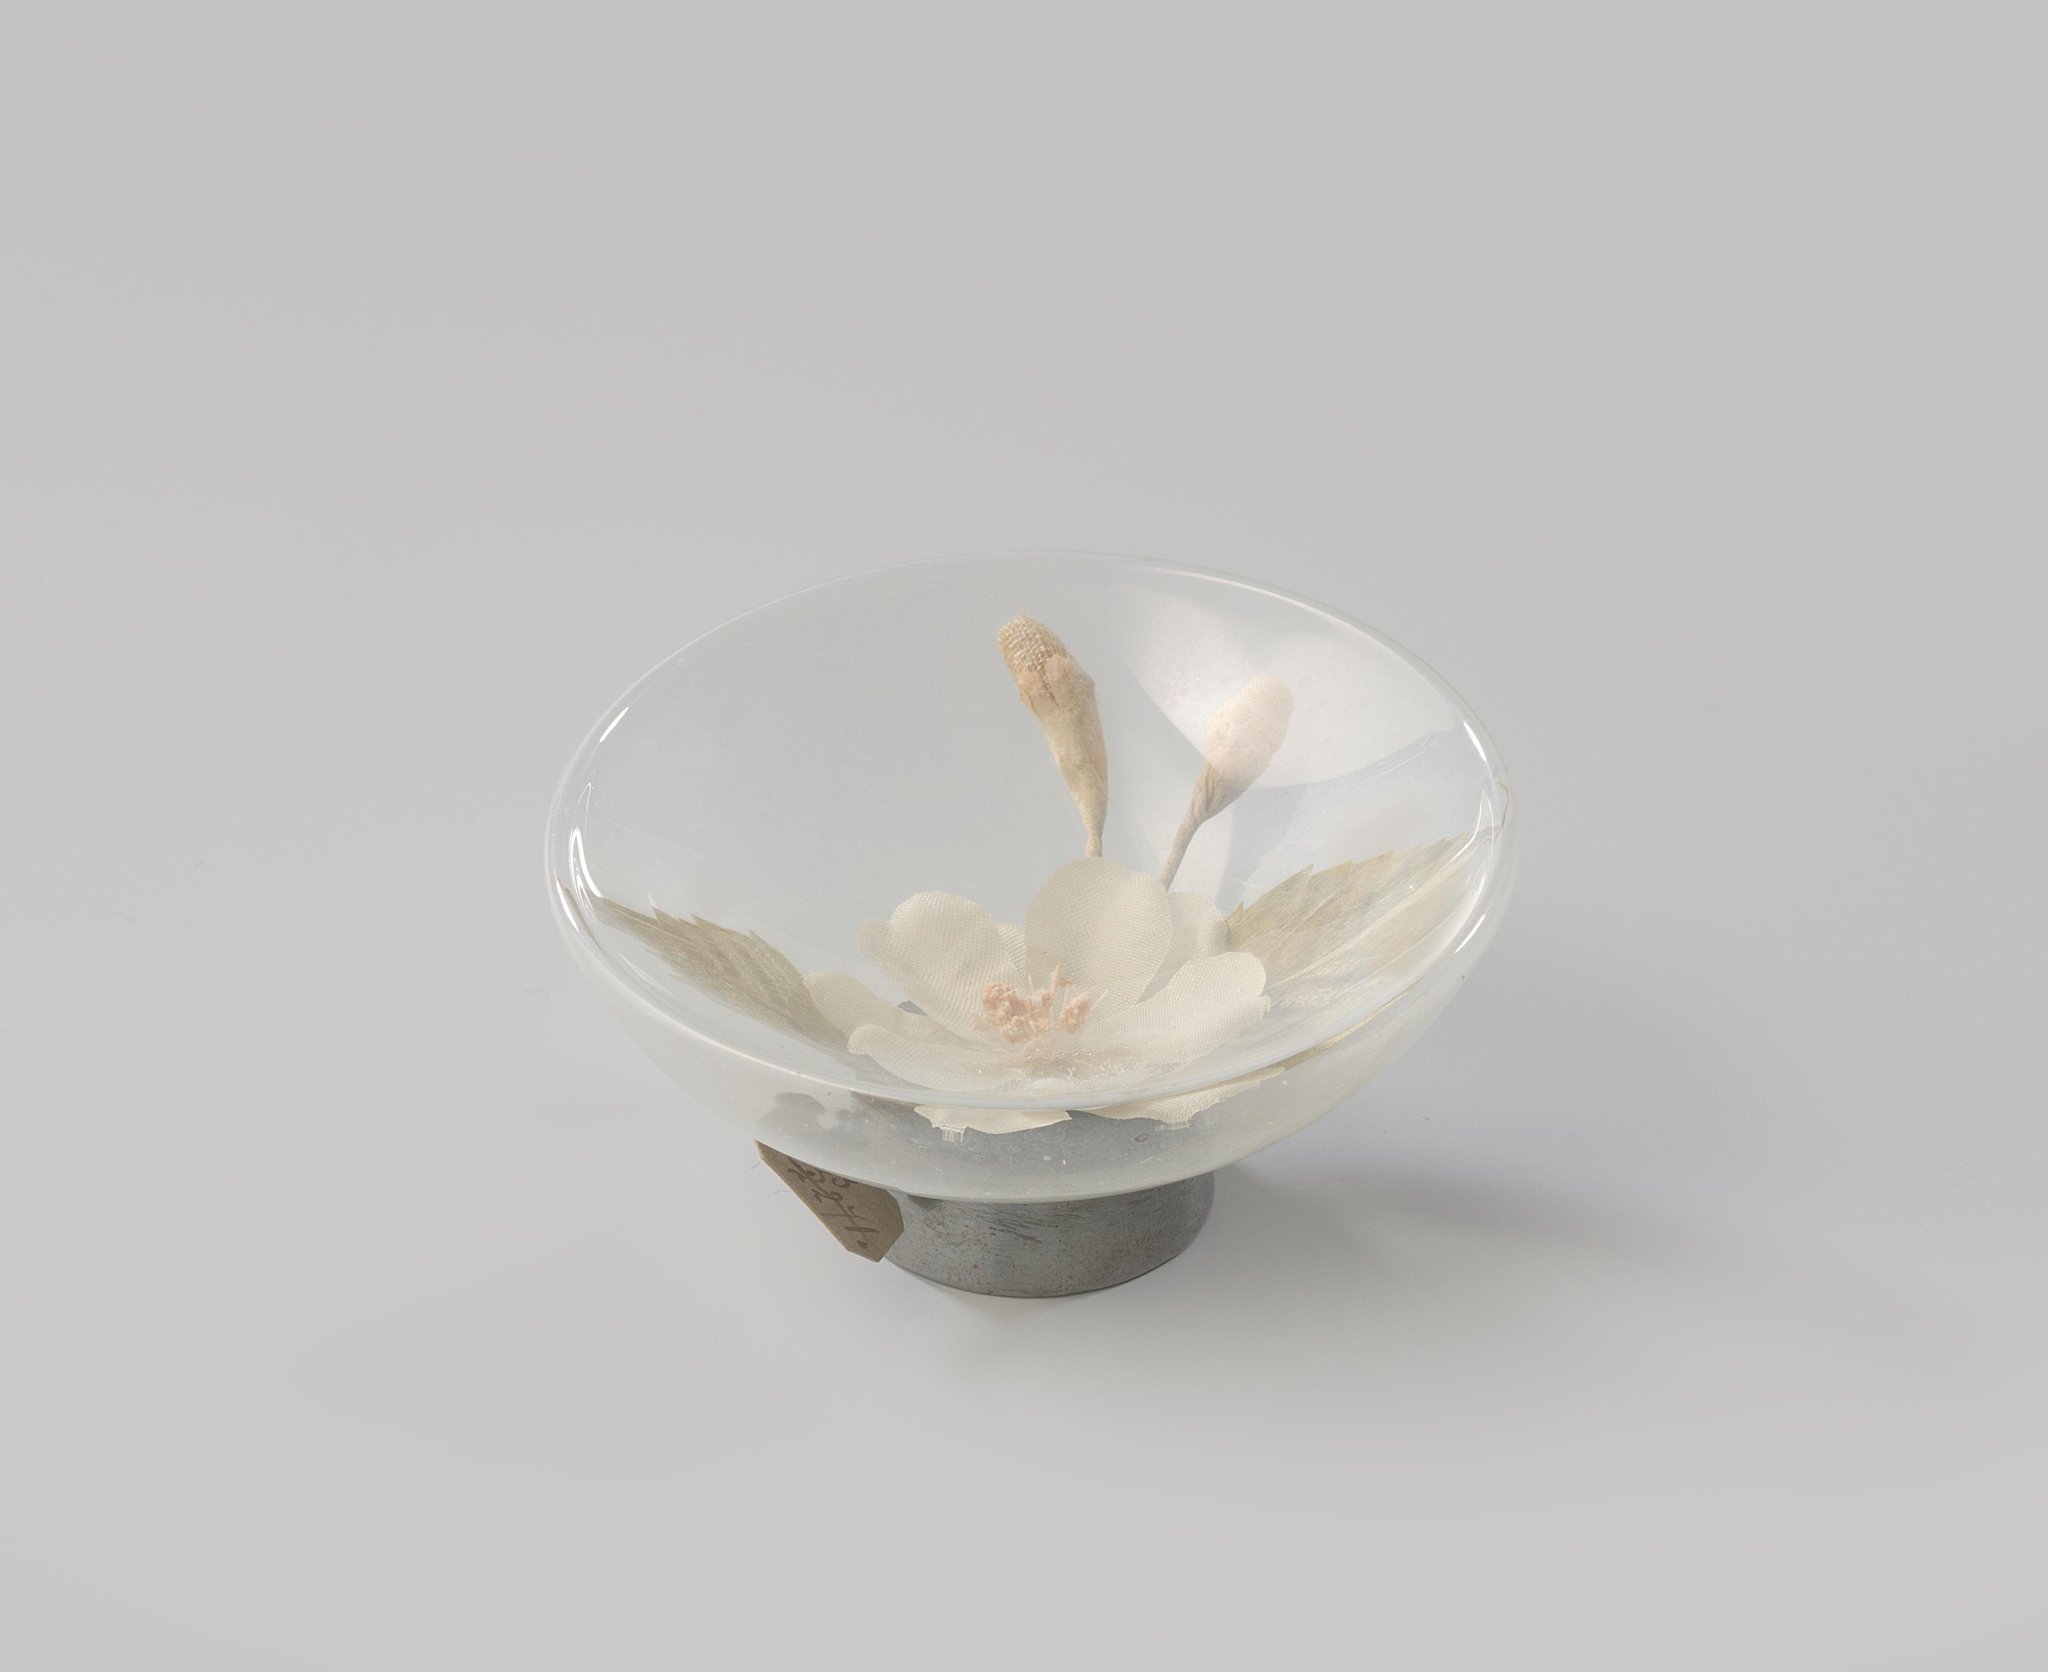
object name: platter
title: Schotel met dubbele wanden, waartussen een bloem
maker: Anonymous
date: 1800-1885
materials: plastic, textile, tin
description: Schotel met dubbele wanden, waartussen een bloem. Tinnen voet.